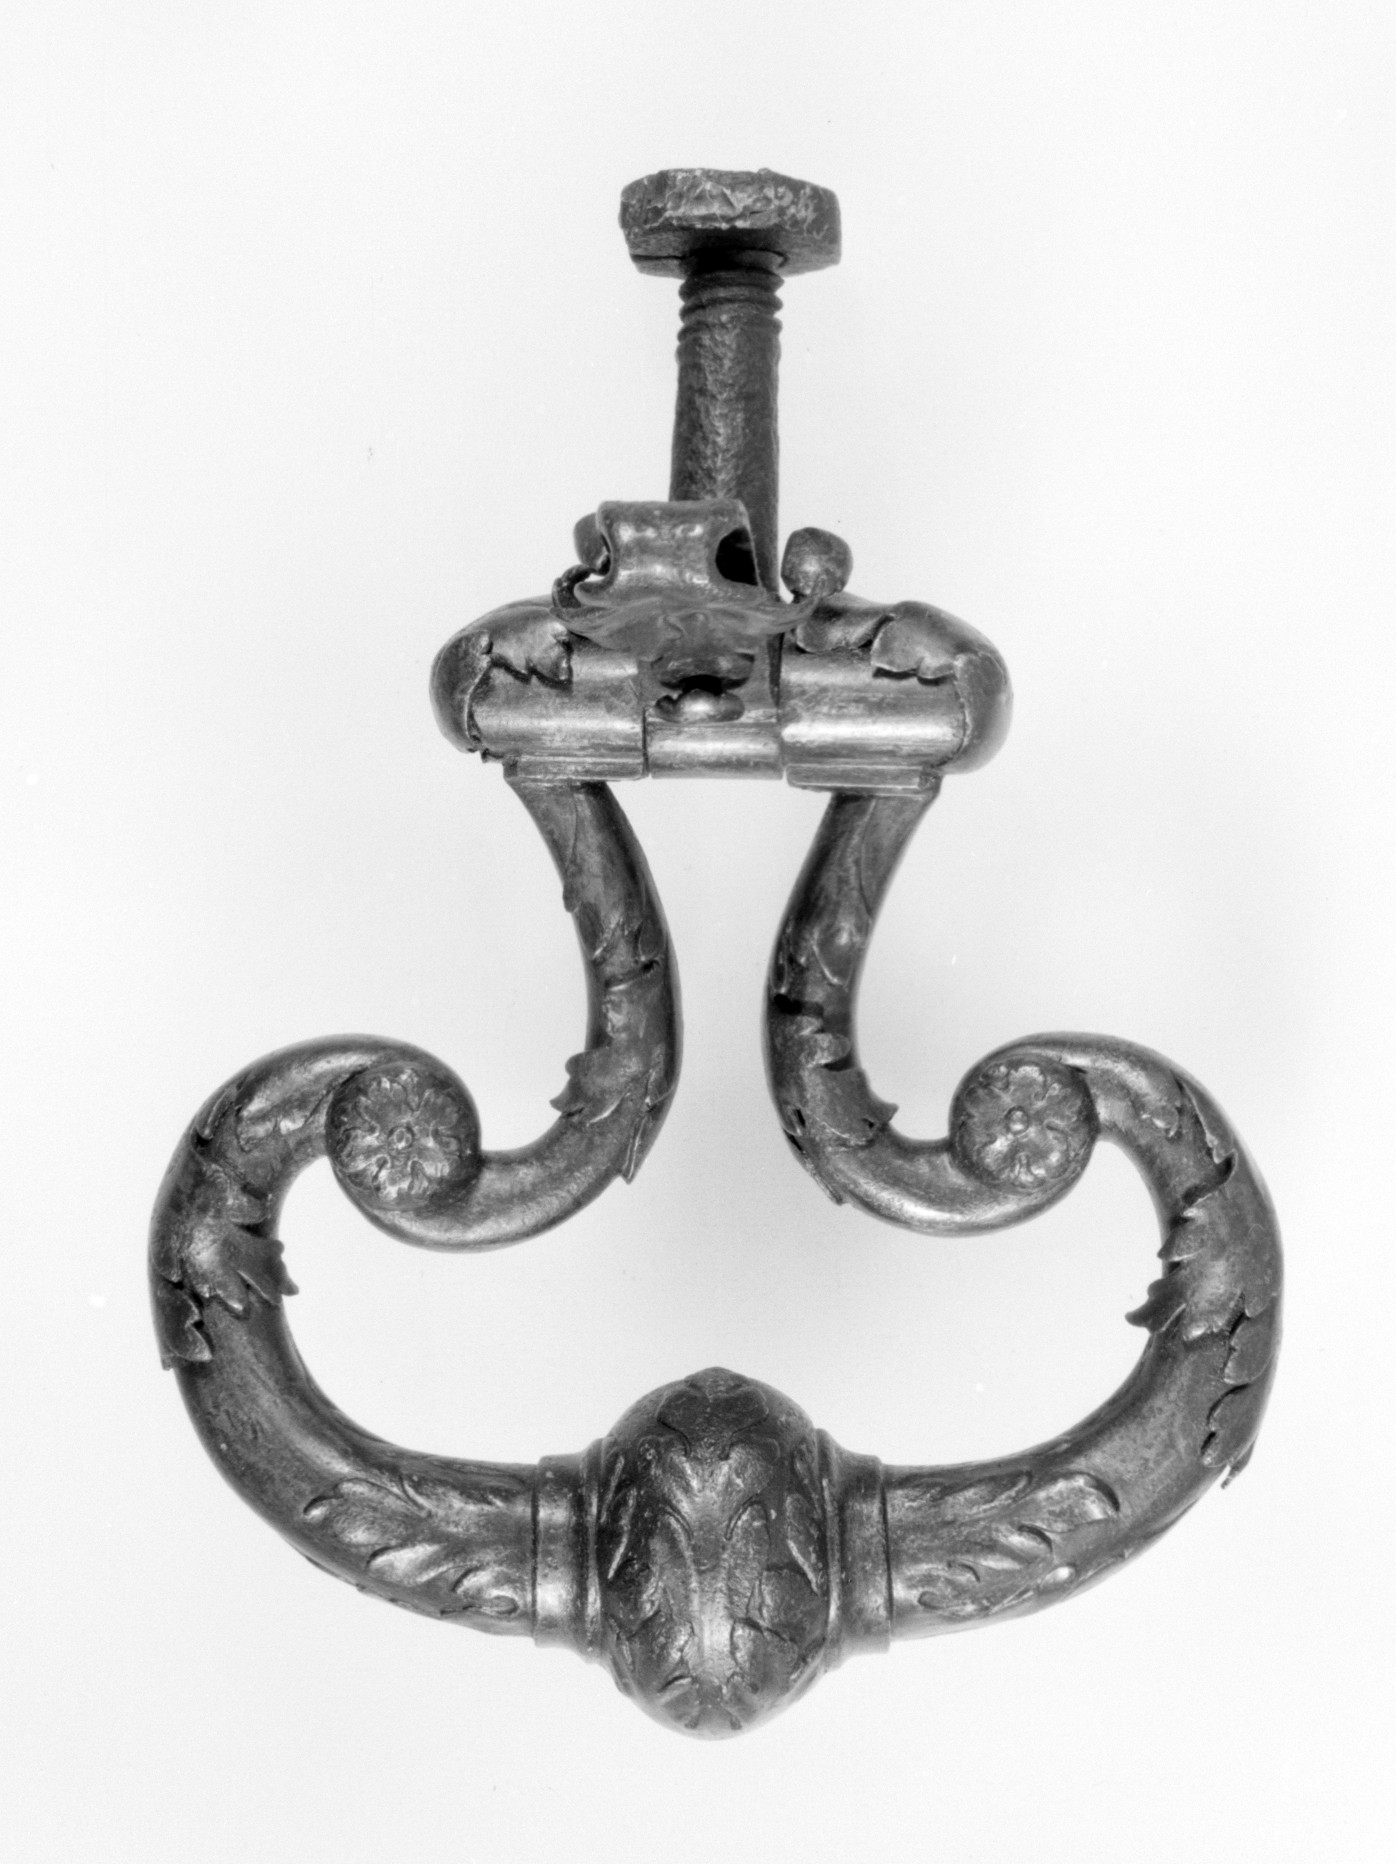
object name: door knocker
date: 1601-1700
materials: iron